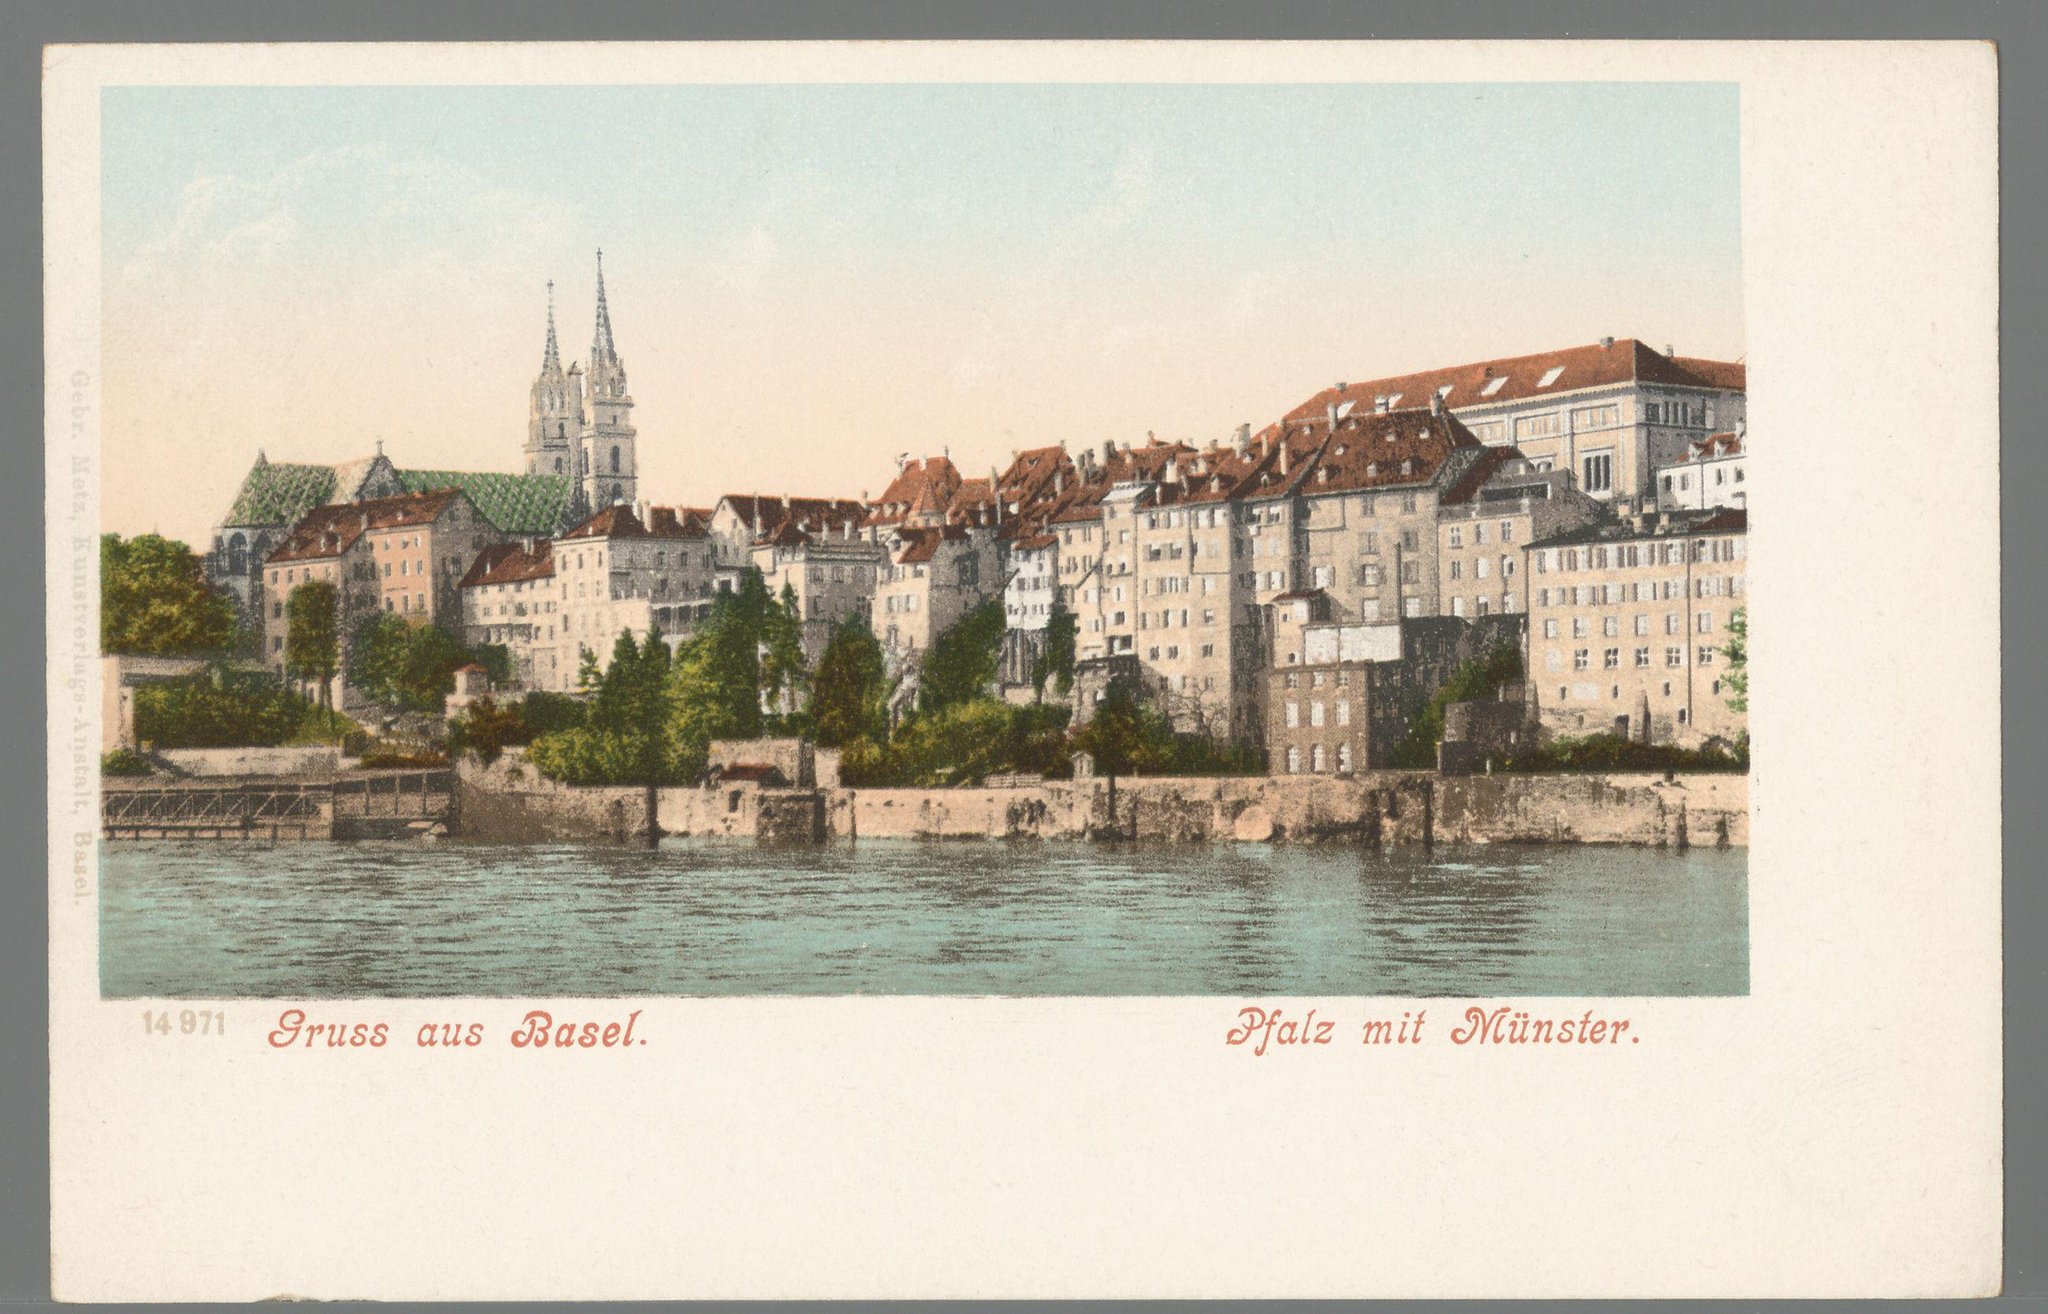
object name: photomechanical print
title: Gruss aus Basel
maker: Anonymous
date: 1898-1905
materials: cardboard, photographic process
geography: basel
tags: city-view, and landscape with man-made constructions, river, church (exterior)